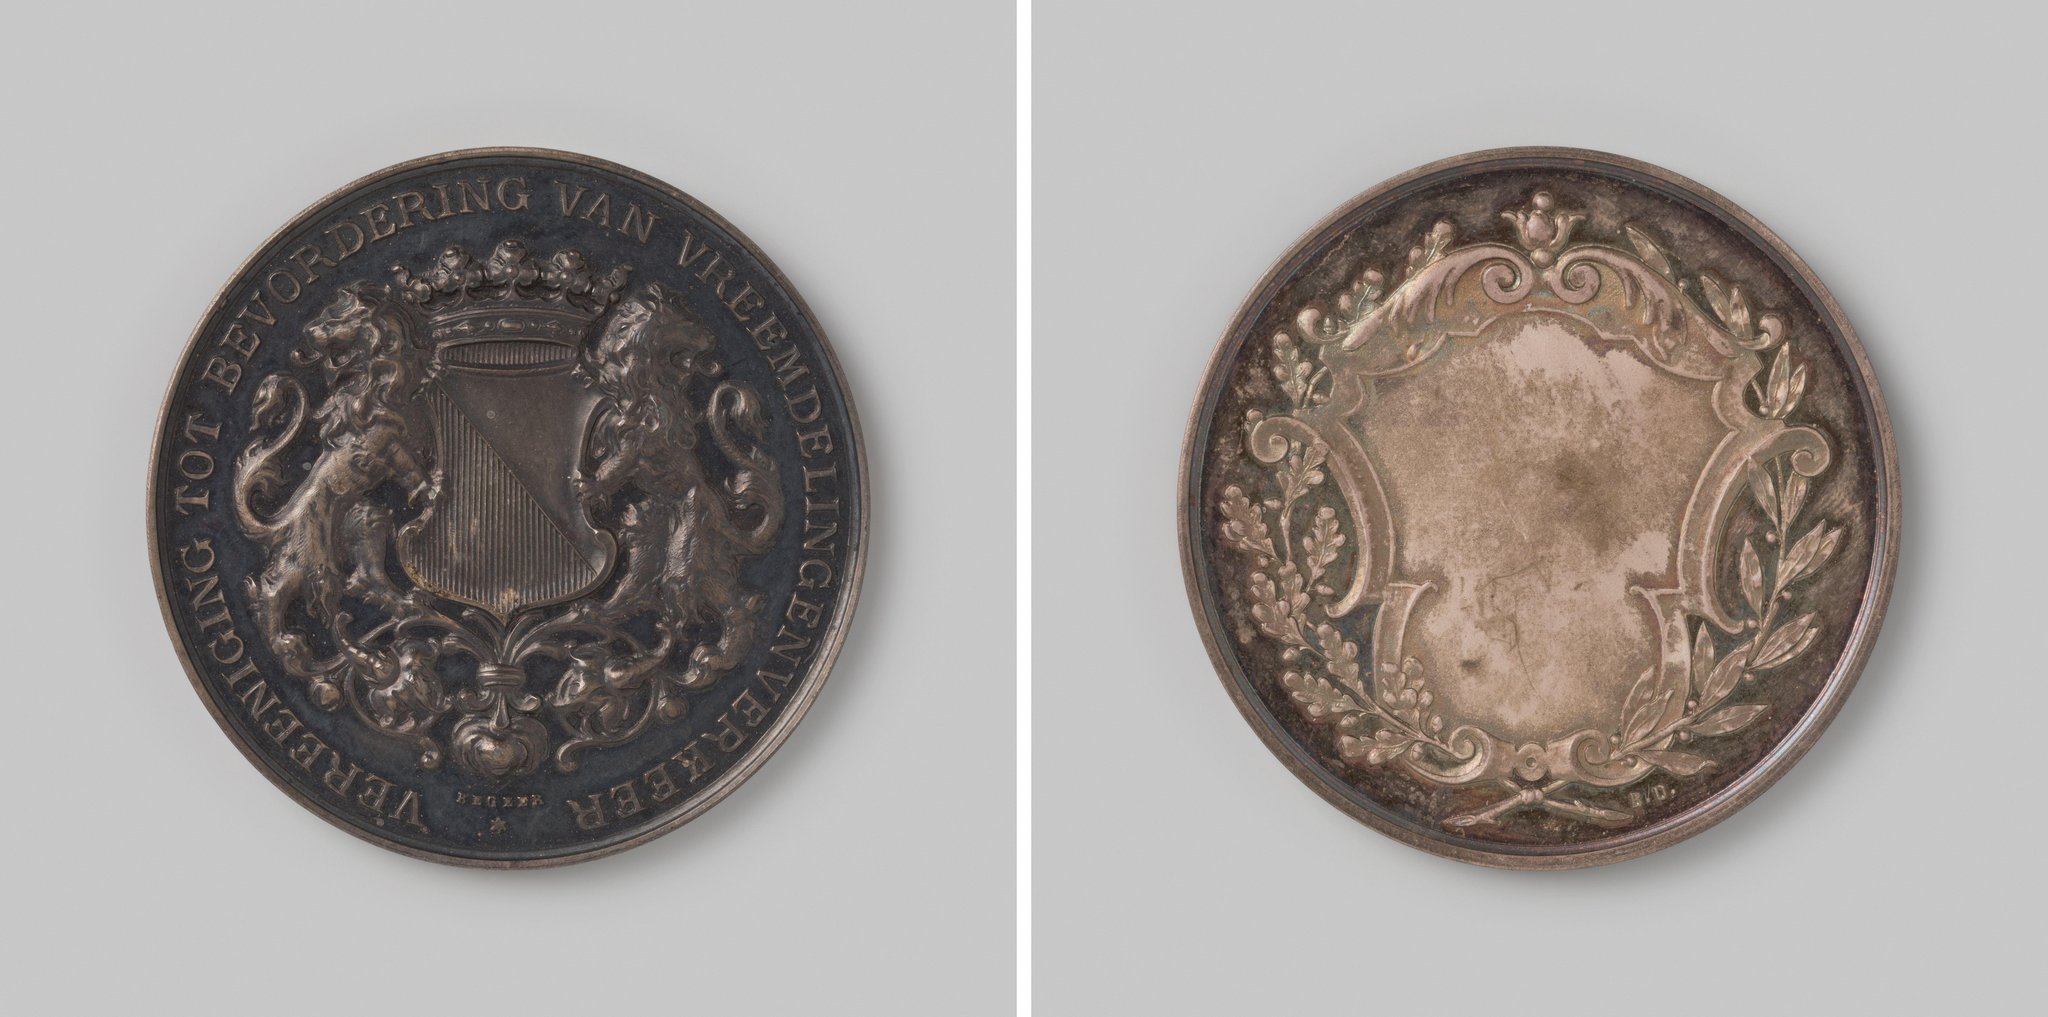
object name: medal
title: Prijspenning van de Vereeniging tot Bevordering van Vreemdelingenverkeer te Utrecht (1892)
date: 1891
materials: silver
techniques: striking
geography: utrecht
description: Zilveren penning, op de voorzijde het gekroonde wapenschild van stad Utrecht met dragers, met omschrift, op de keerzijde een cartouche met inscriptieruimte tussen eiken- en lauwertakken.